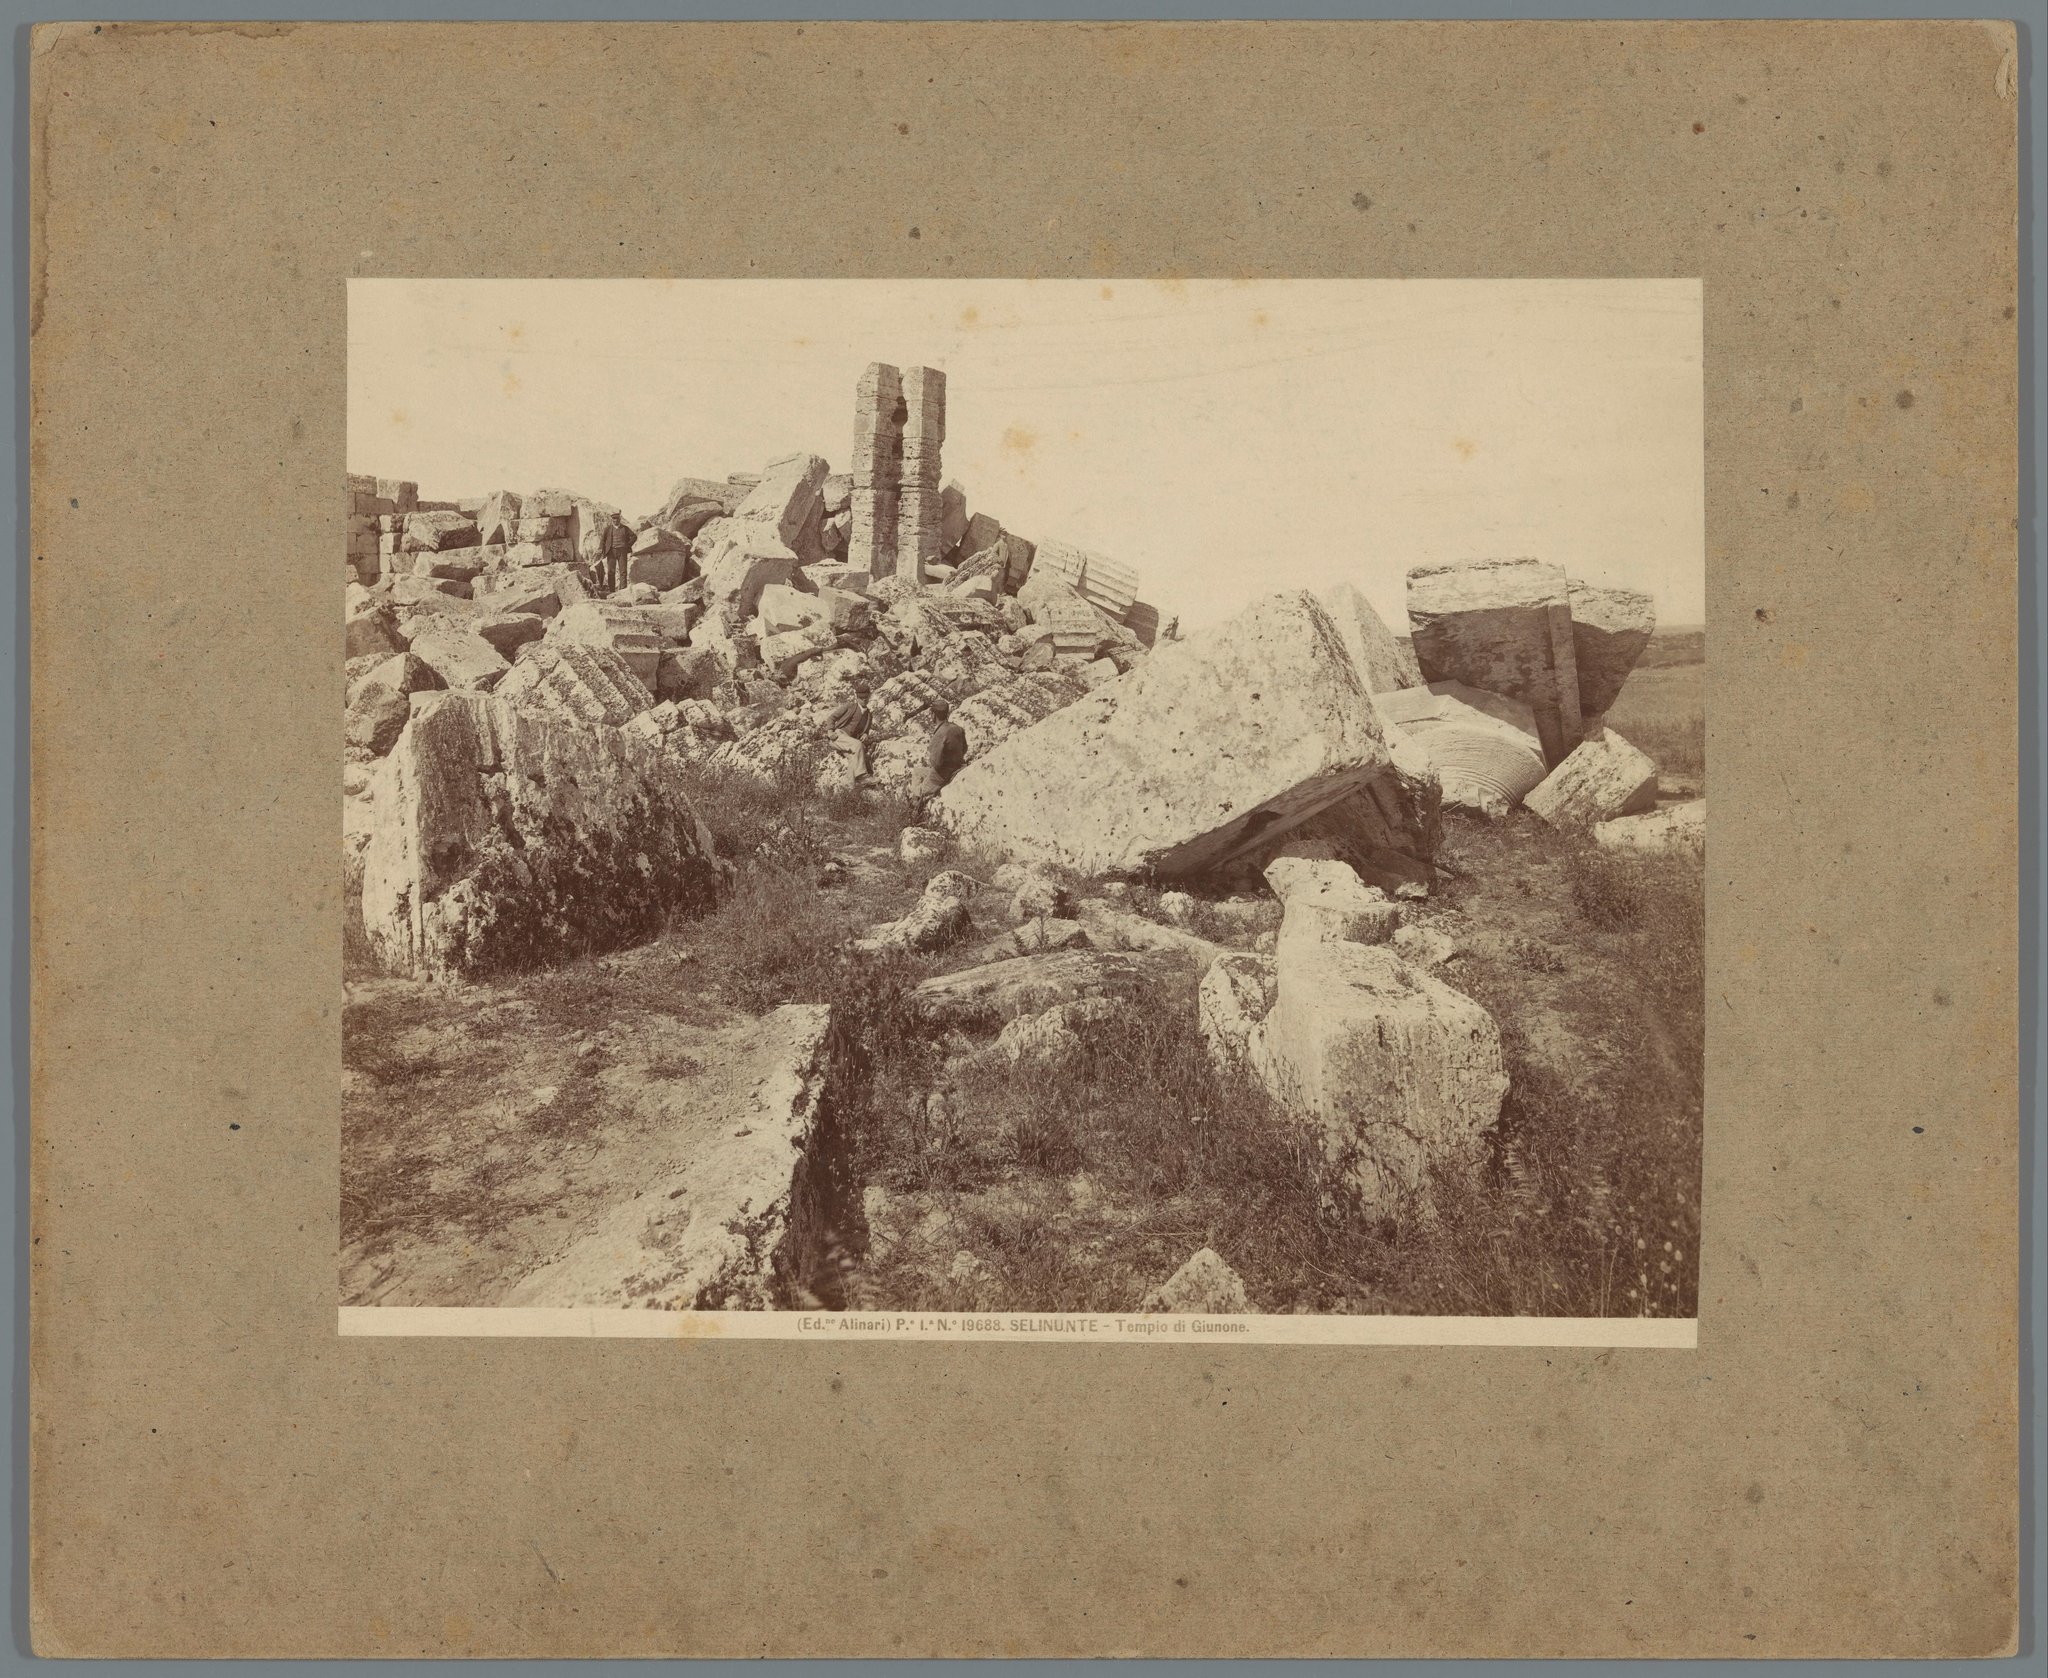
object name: photograph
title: SELINUNTE - Tempio d'Apollo.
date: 1875-1900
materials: cardboard, photographic support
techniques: albumen print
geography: selinunte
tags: ruin of a building ~ architecture, temple, shrine ~ roman religion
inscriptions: number: ‘P.e I.a N.o 19688.’, inscription: ‘DI. 5 Romijns’, collector's mark: Lugt 3937